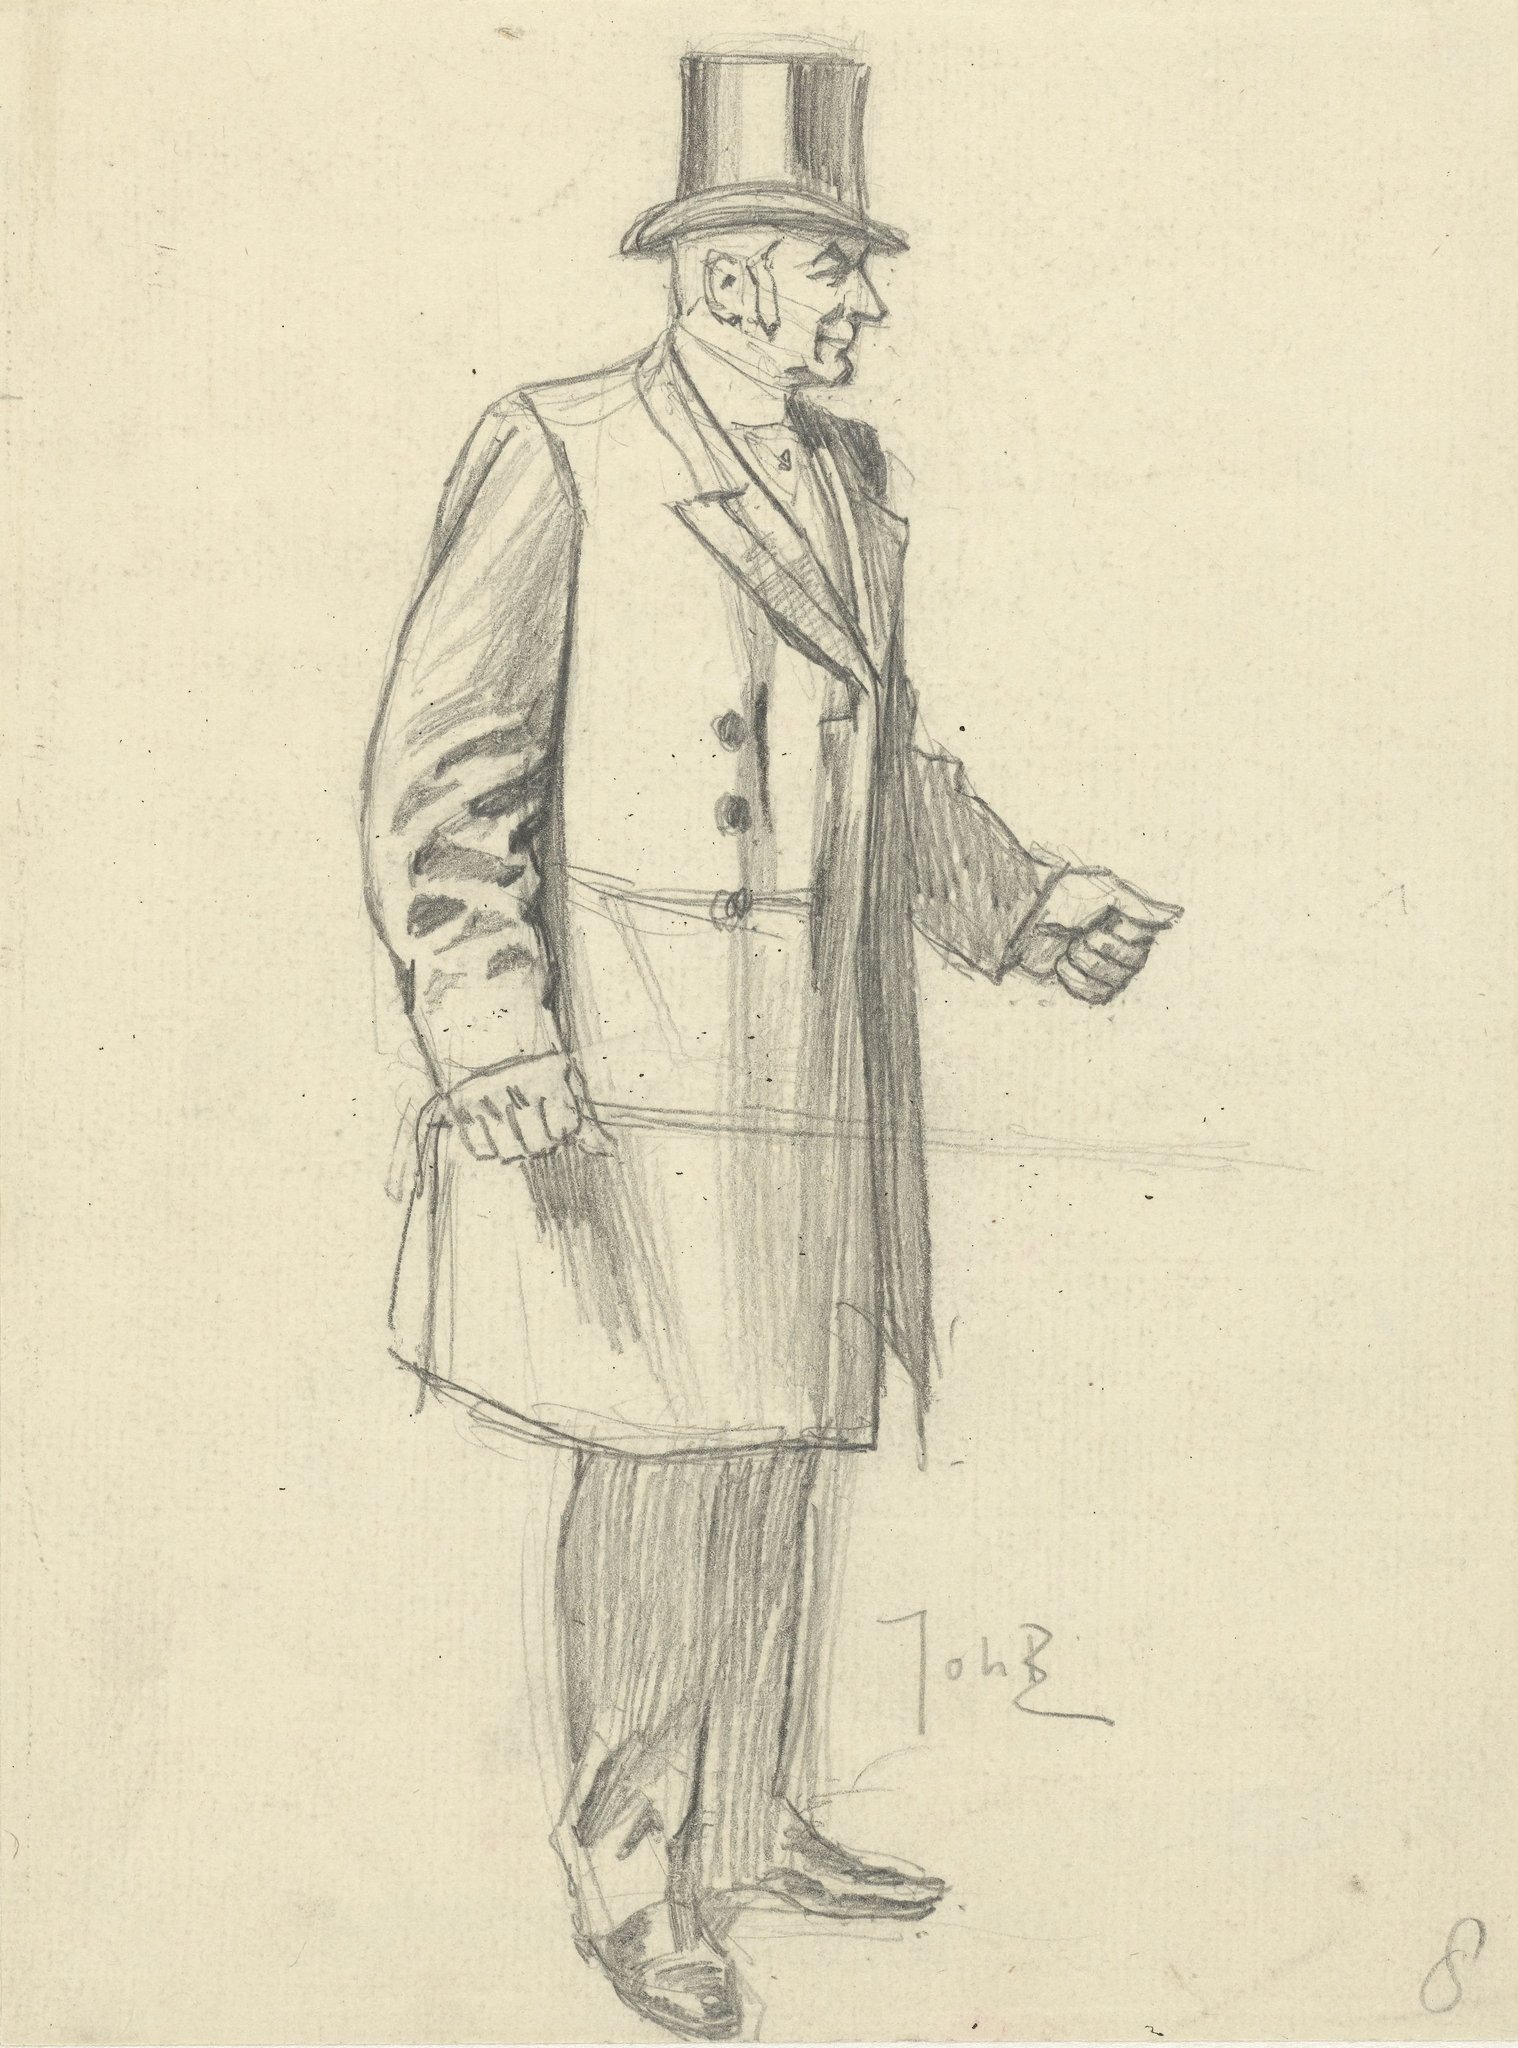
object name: design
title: Portret van Minister de Savornin Lohman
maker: johan braakensiek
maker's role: draughtsman, print maker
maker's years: 1858-1940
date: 1868-1940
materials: paper, pencil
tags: the hague, jonkheer alexander frederik de savornin lohman, historical persons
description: Portret van Minister de Savornin Lohman; ontwerp voor de spotprent 'In het Pruisische Huis van Afgevaardigden'. Ontwerp voor een prent.